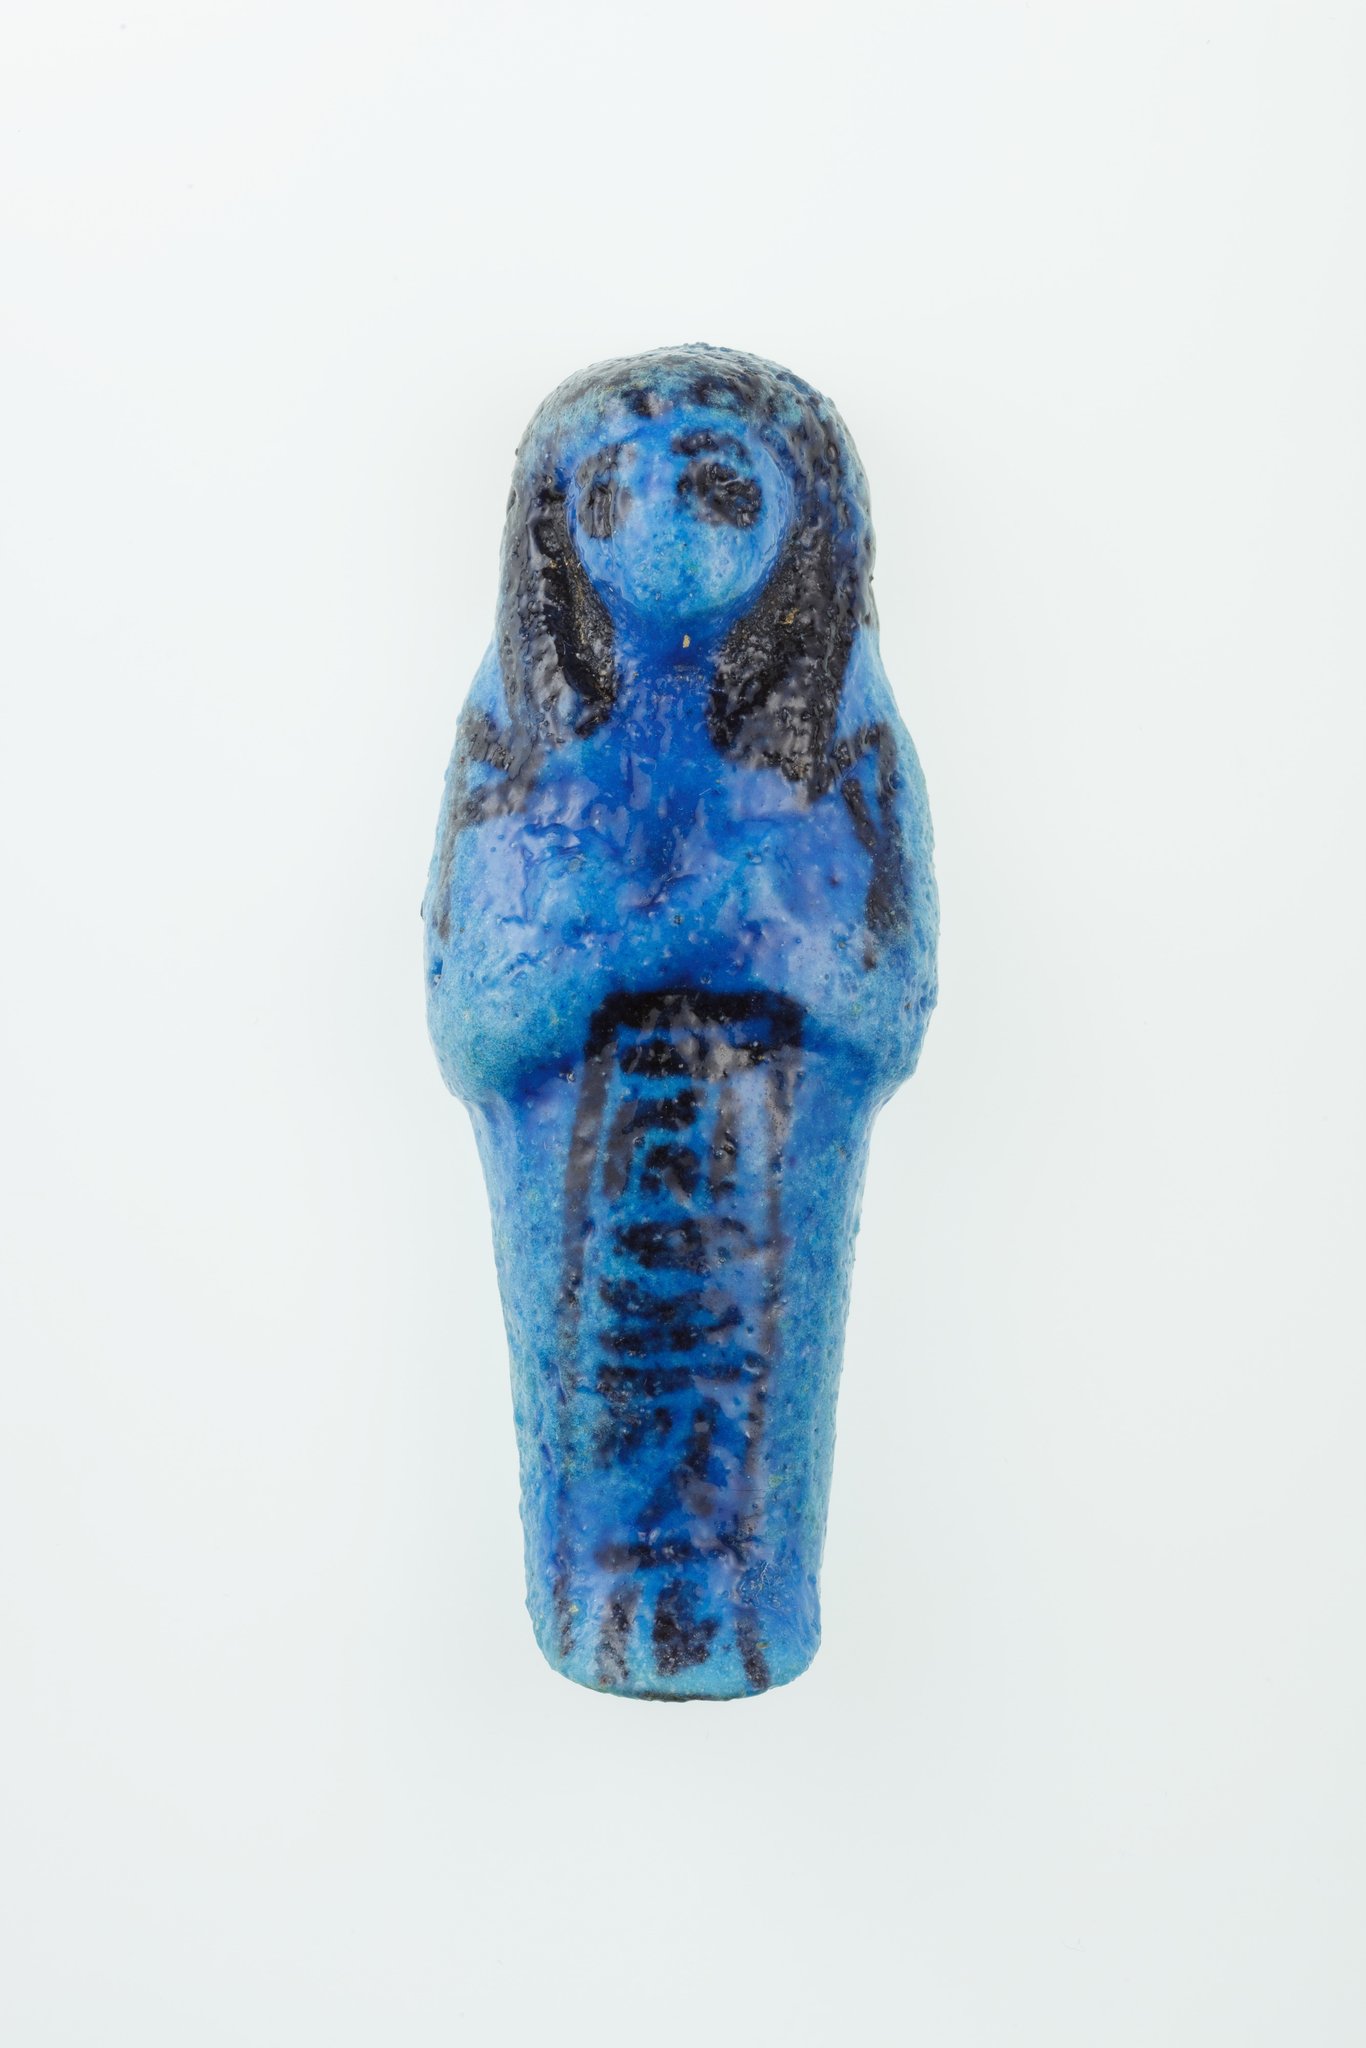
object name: shabti, worker, nauny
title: Worker Shabti of Nauny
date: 1050 BCE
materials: faience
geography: egypt